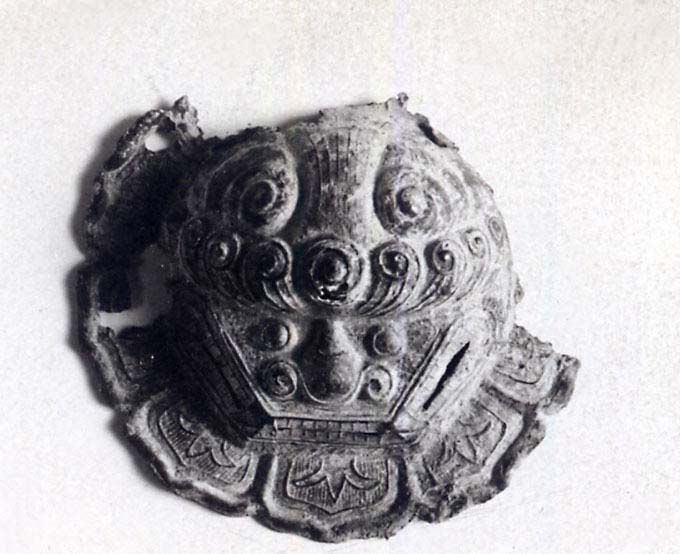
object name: mask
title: Mask of a Lion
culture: chinese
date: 206 BCE-220 CE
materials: pewter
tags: masks